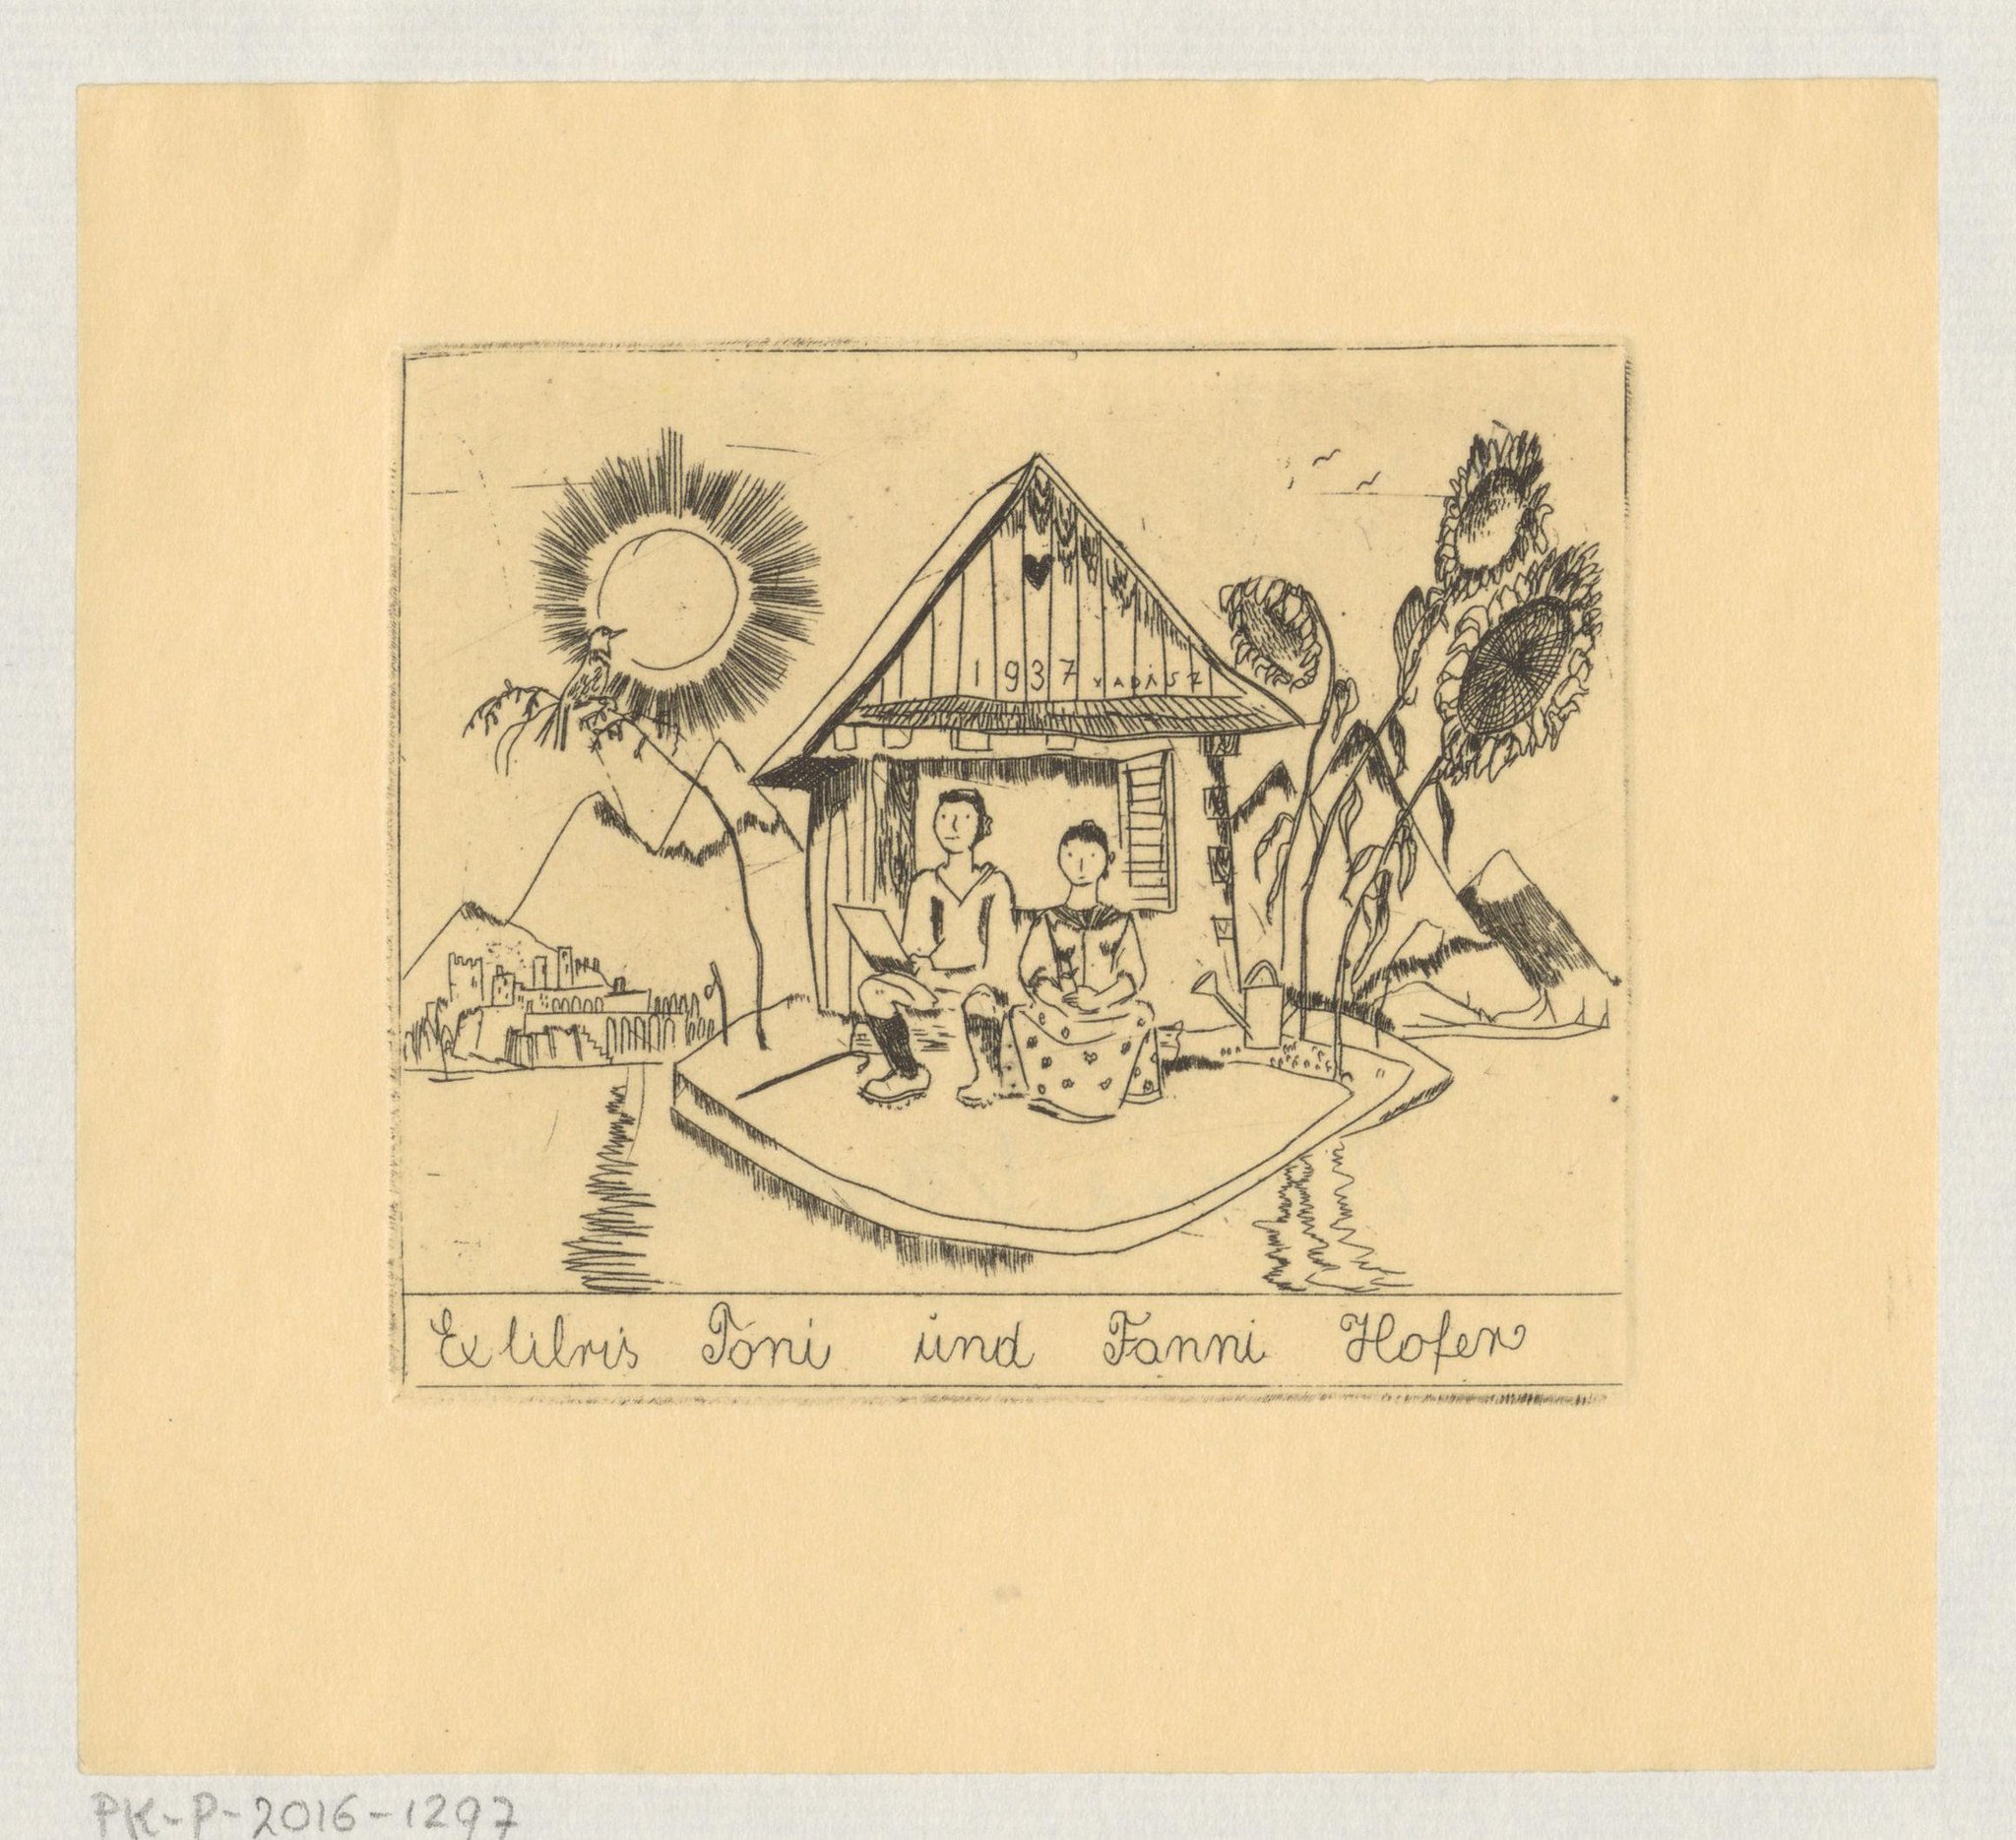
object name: bookplate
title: Ex libris van Fanni en Toni Hofer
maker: endre vadász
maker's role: painter, print maker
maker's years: 1901-1944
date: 1937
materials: paper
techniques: etching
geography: hungary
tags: painter, toni hofer, island, family life at home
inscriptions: date